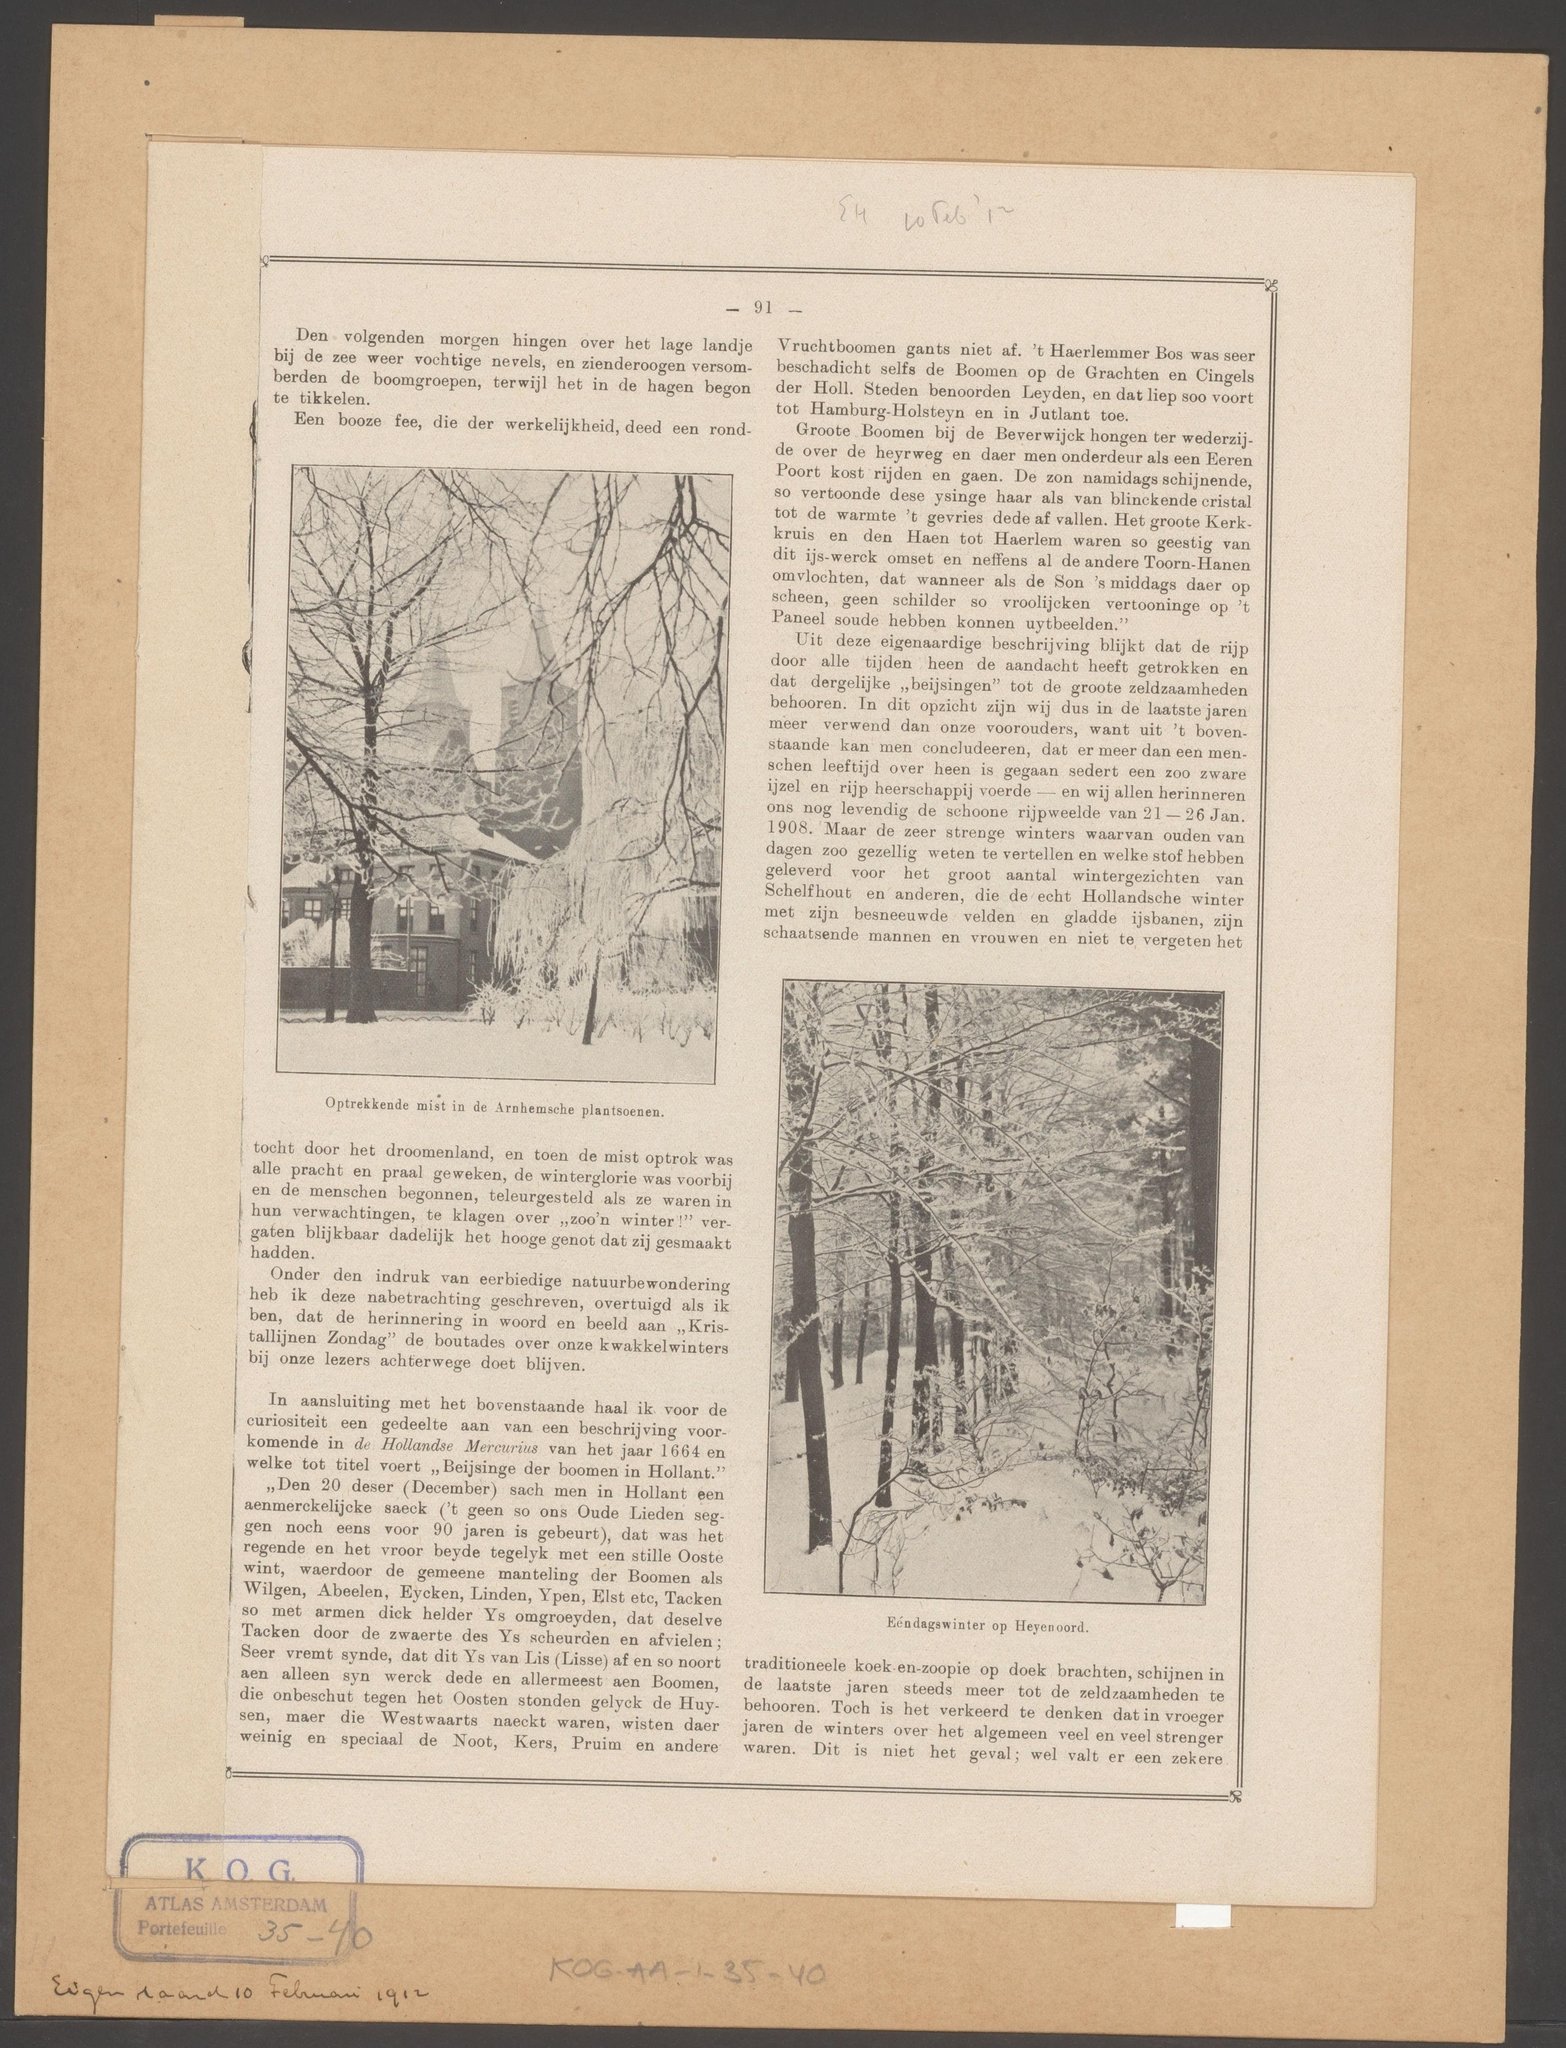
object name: article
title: Ons-Lieve-Heer-Op-Solder. Kerk van den Heiligen Nicolaas, bijgenaamd: "Het Hert" te Amsterdam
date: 1912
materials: paper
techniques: letterpress printing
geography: amsterdam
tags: city-view in general; 'veduta', church (exterior), interior of church, canals, waters (in city)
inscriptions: collector's mark: ‘35-40’ Lugt 1641b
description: Object bestaande uit zes pagina's (91-96) uit Eigen Haard (1912), met negen autotypieën. Onderwerpsrubriek binnen de Atlas Amsterdam: Kerkwezen: Hervormde Gemeente: Oude Kerk van buiten.